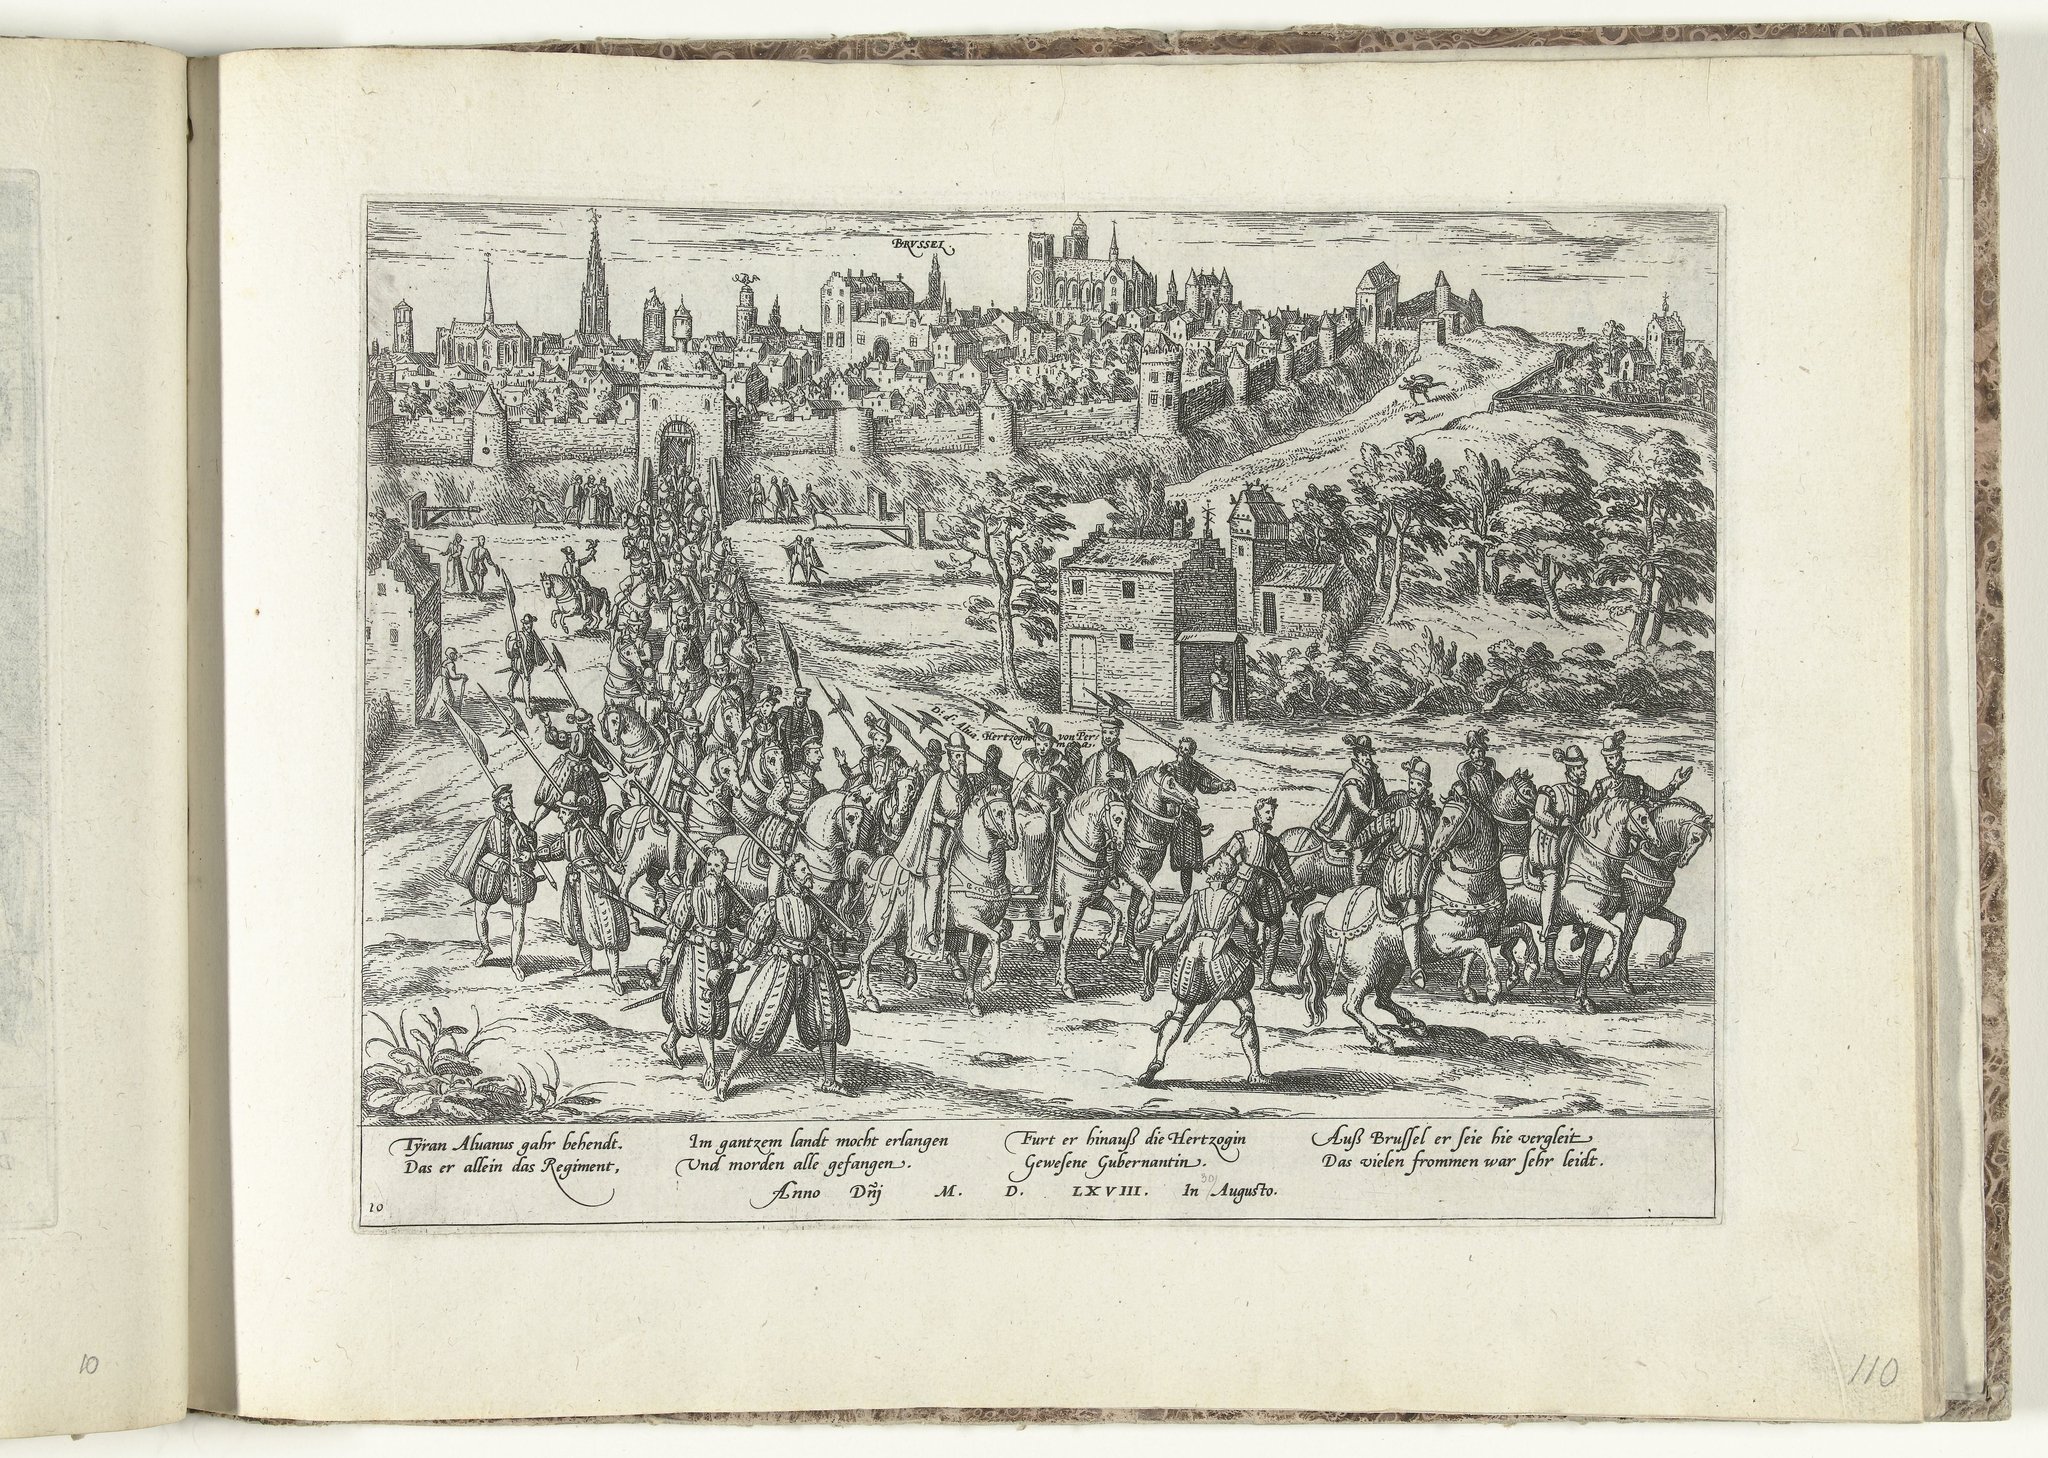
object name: print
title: Margaretha van Parma door Alva uitgeleid, 1568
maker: frans hogenberg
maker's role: print maker, publisher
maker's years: 1538-1590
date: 1568-1570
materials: paper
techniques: etching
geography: cologne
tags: fernando álvarez de toledo (3rd duke of alba), law and jurisprudence (+ arrest), brussels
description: Margaretha van Parma door Alva Brussel uitgeleid, 30 augustus 1568. Stoet met Alva en de landvoogdes verlaat de stad, op de achtergrond de ommuurde stad. Met onderschrift van 8 regels in het Duits. Genummerd: 10. De prent maakt deel uit van een album.